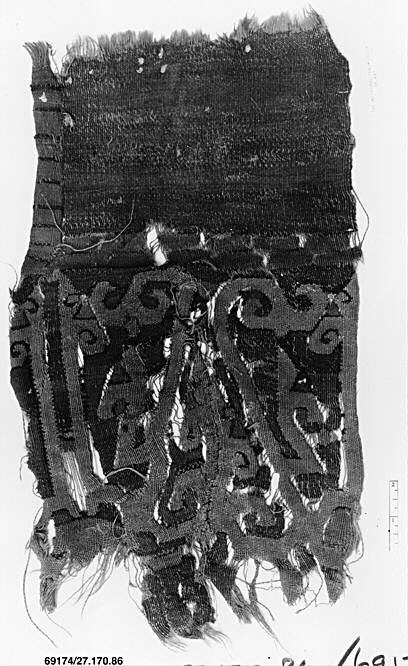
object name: textile fragment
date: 1001-1100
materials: wool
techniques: weave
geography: egypt